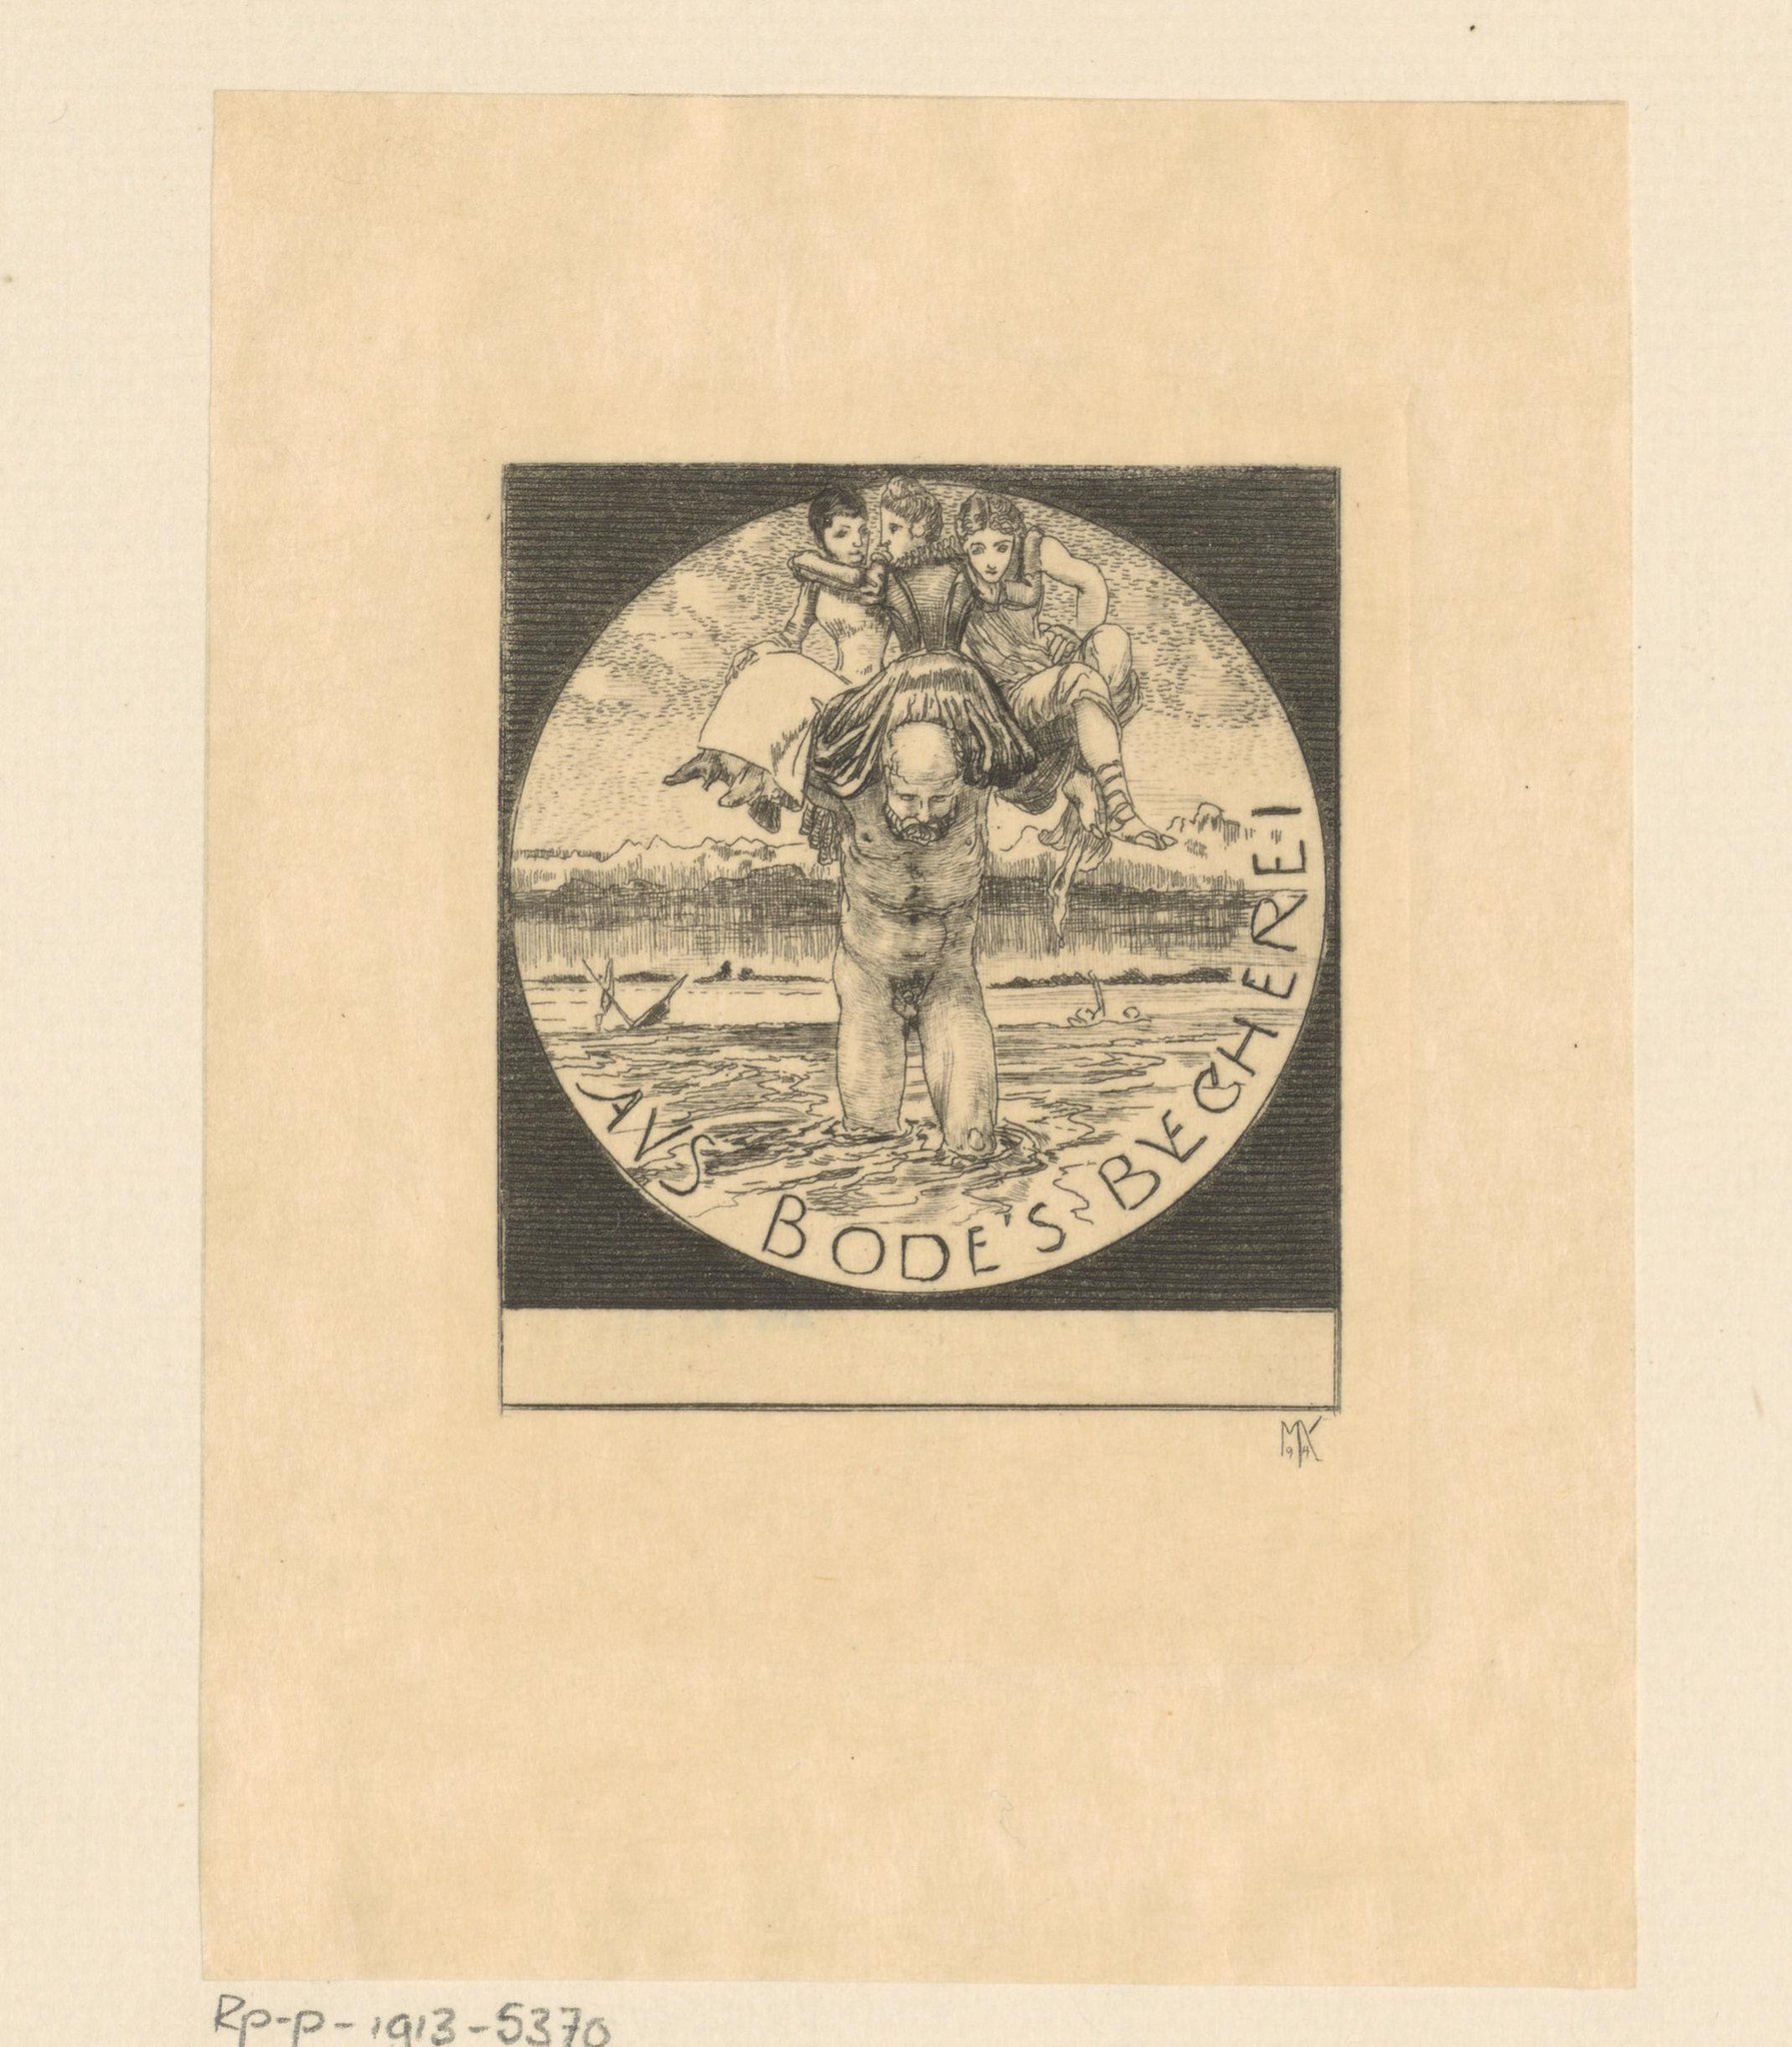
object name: bookplate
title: Aus Bode's Bucherei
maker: max klinger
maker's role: print maker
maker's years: 1857-1920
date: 1894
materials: paper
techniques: etching, intaglio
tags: carrying a person on one's back, saving a person from drowning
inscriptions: collector's mark: Lugt 2233, collector's mark: Lugt 2760